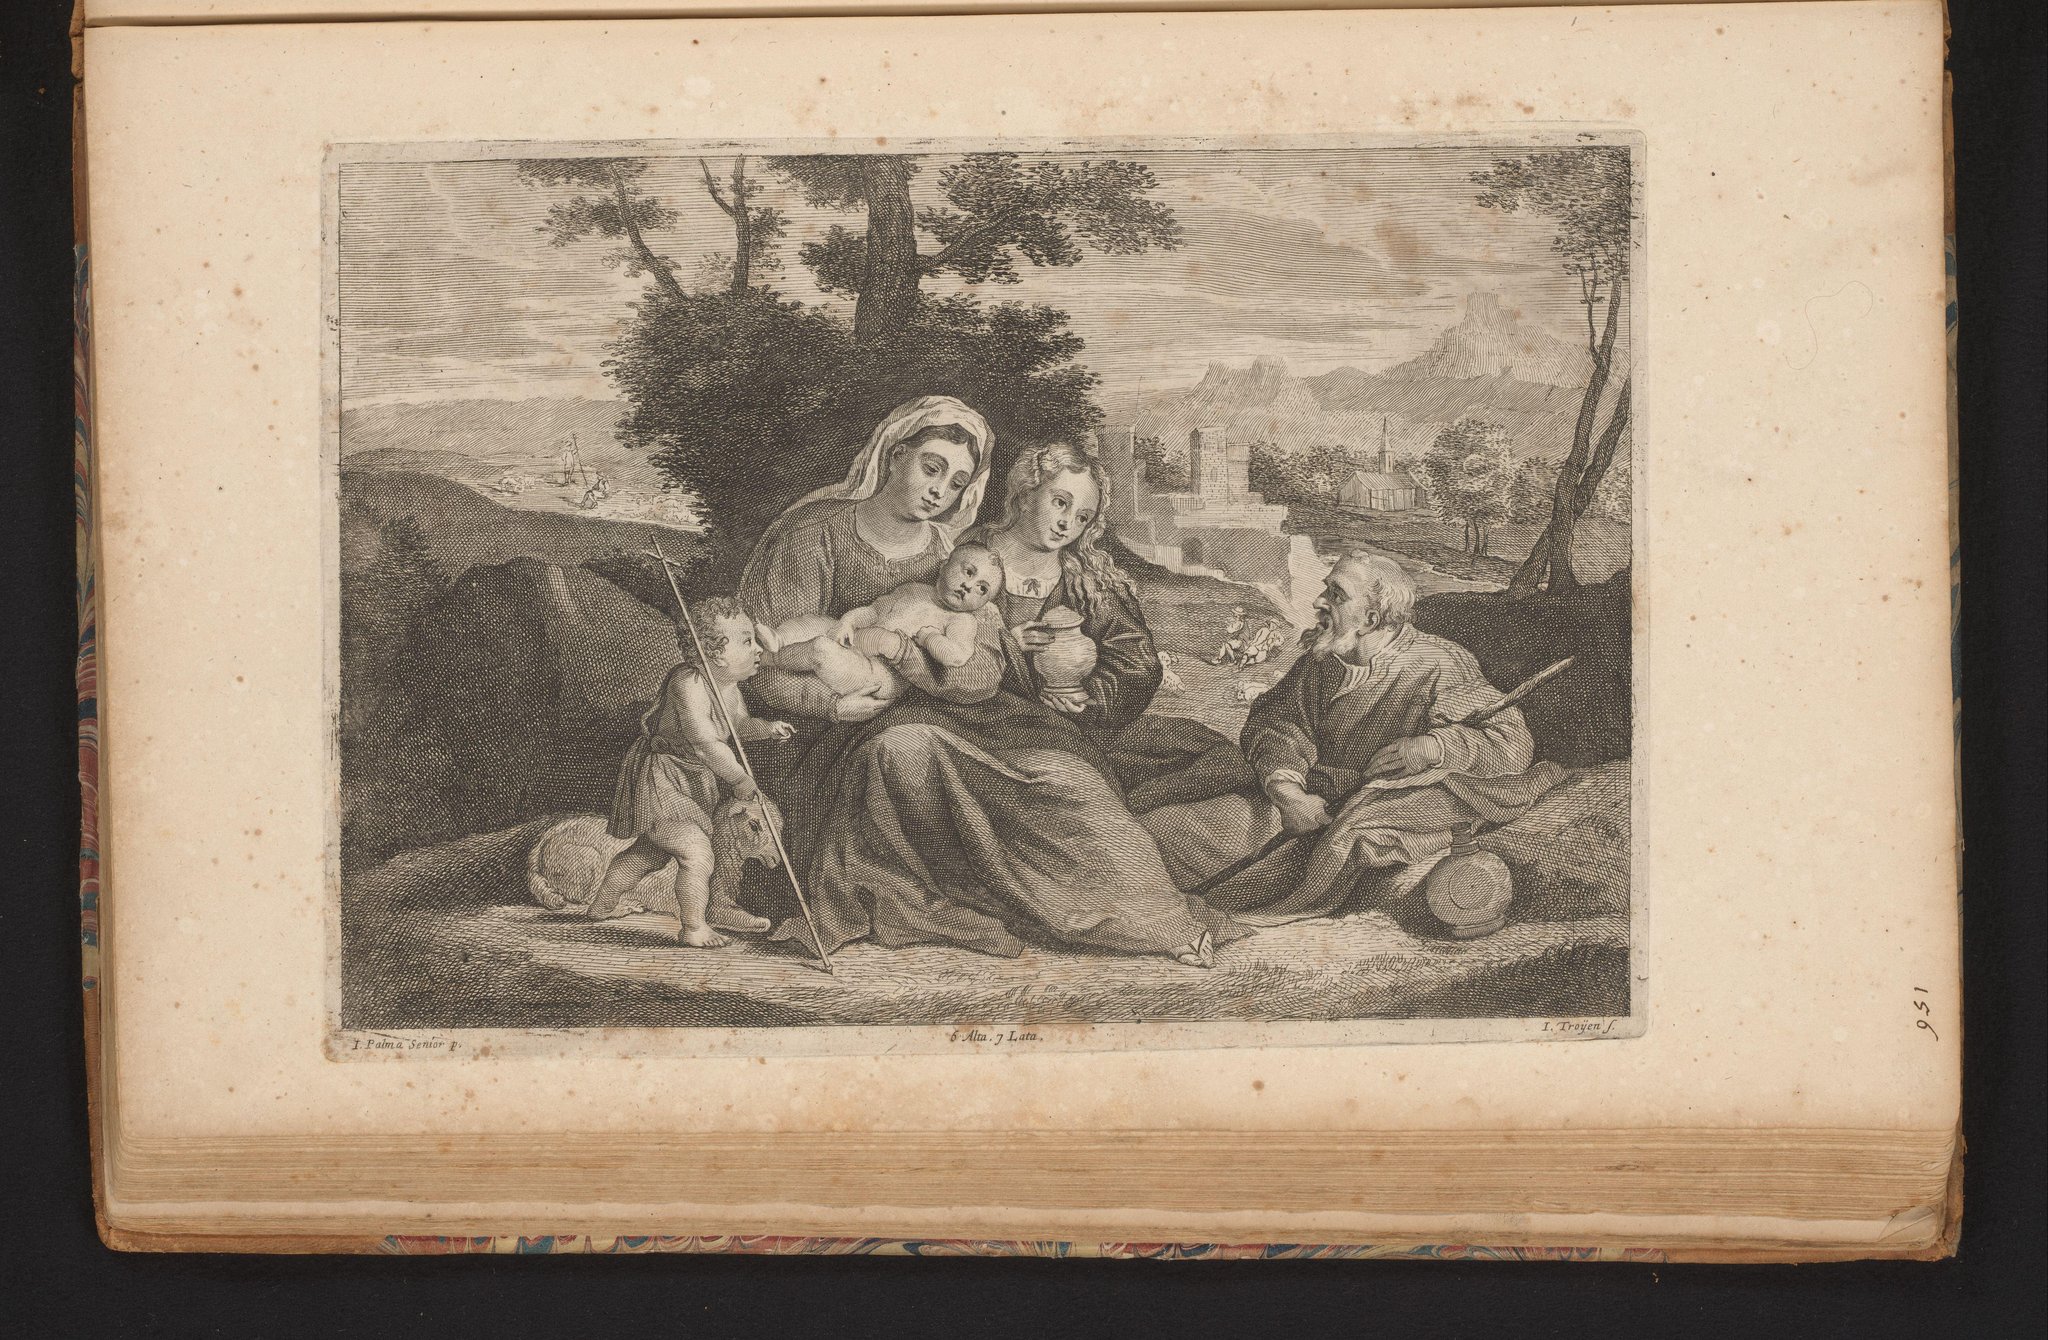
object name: album leaf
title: Heilige Familie met de jonge Johannes de Doper en Maria Magdalena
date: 1660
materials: paper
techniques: engraving, etching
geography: southern netherlands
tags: holy family with john the baptist (as child), the penitent harlot mary magdalene; possible attributes: book (or scroll), crown, crown of thorns, crucifix, jar of ointment, mirror, musical instrument, palm-branch, rosary, scourge, mountains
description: De prent is vervaardigd naar het schilderij van Palma dat zich in de collectie van het Uffizi te Florence bevindt (inventarisnummer 950). De geschilderde kopie van Teniers bevindt zich in de collectie van het Kunsthistorisches Museum te Wenen (inventarisnummer GG_9008). David Teniers heeft waarschijnlijk van alle schilderijen uit de collectie van Leopold Willem van Oostenrijk een olieverfstudie op doek of paneel vervaardigd (zgn. pasticcio), die als voorbeeld voor de prentmakers diende. Het is niet altijd duidelijk of de pasticci door hem zijn gemaakt of door zijn atelier. Niet alle pasticci zijn overgeleverd.